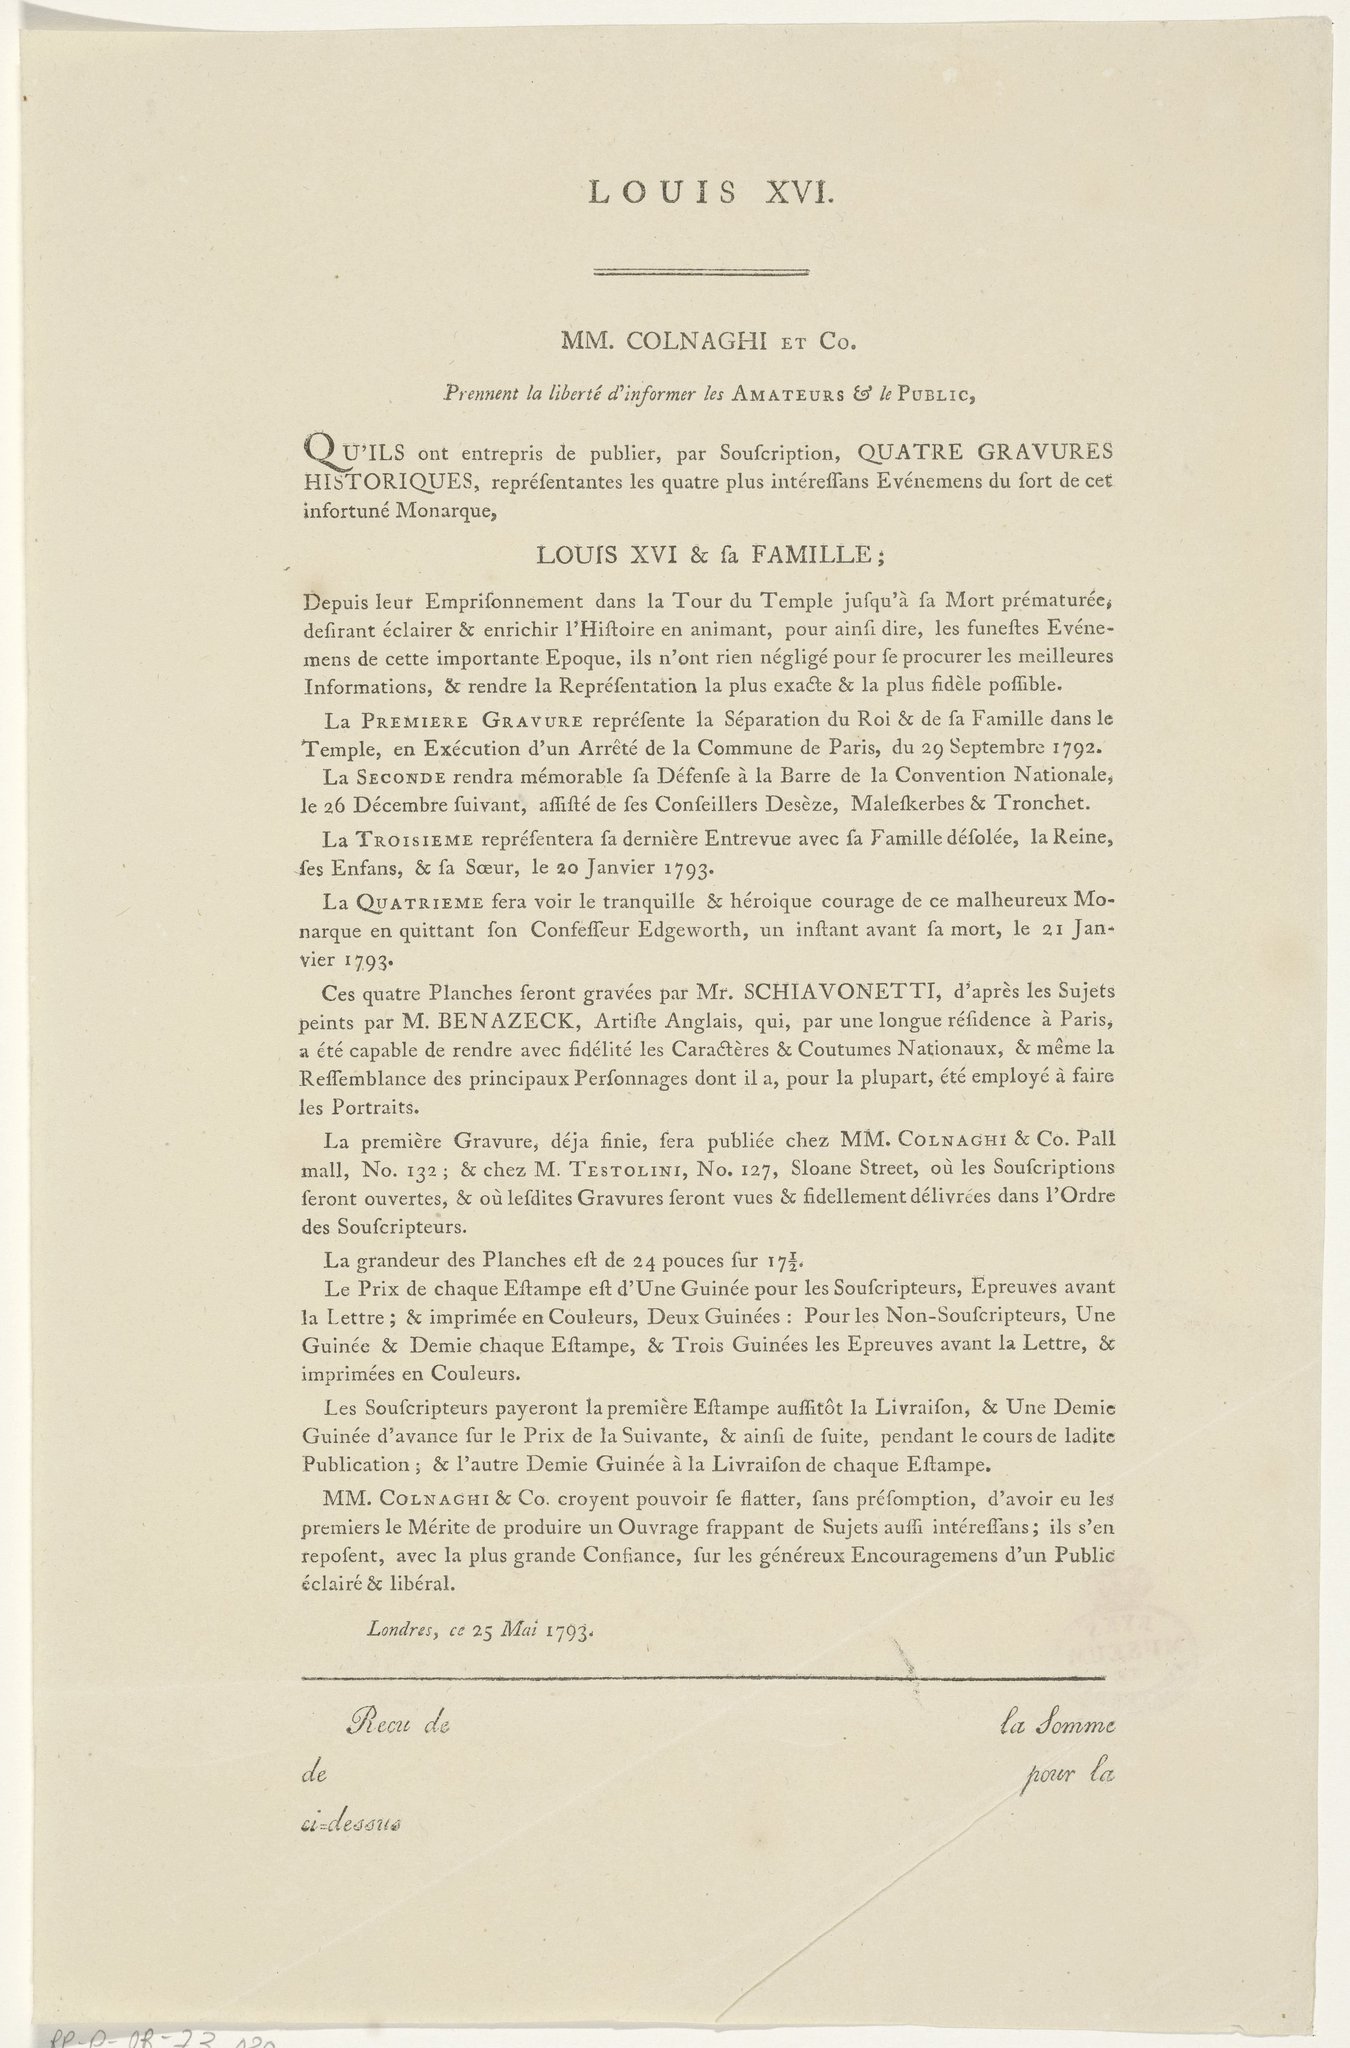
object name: uitgeversprospectus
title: Aankondiging van de prentreeks over de laatste dagen van Lodewijk XVI door Luigi Schiavonetti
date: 1793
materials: paper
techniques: letterpress printing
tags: paris, lodewijk xvi (koning van frankrijk)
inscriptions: collector's mark: Lugt 12